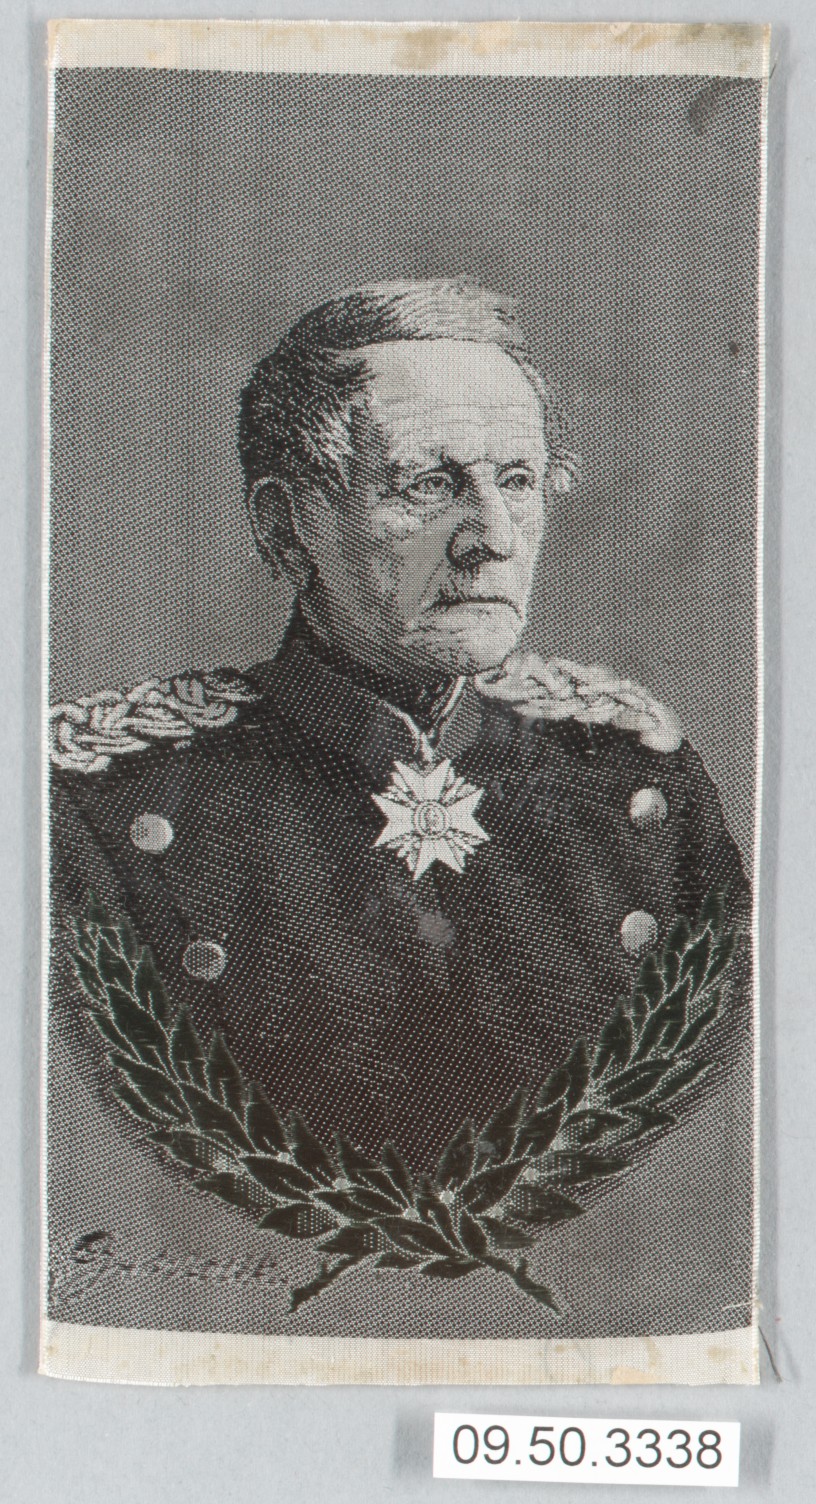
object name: portrait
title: Graf von Moltke (Helmuth Karl Bernhard, 1800–1891)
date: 1867-1900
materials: silk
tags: men,portraits,leaves